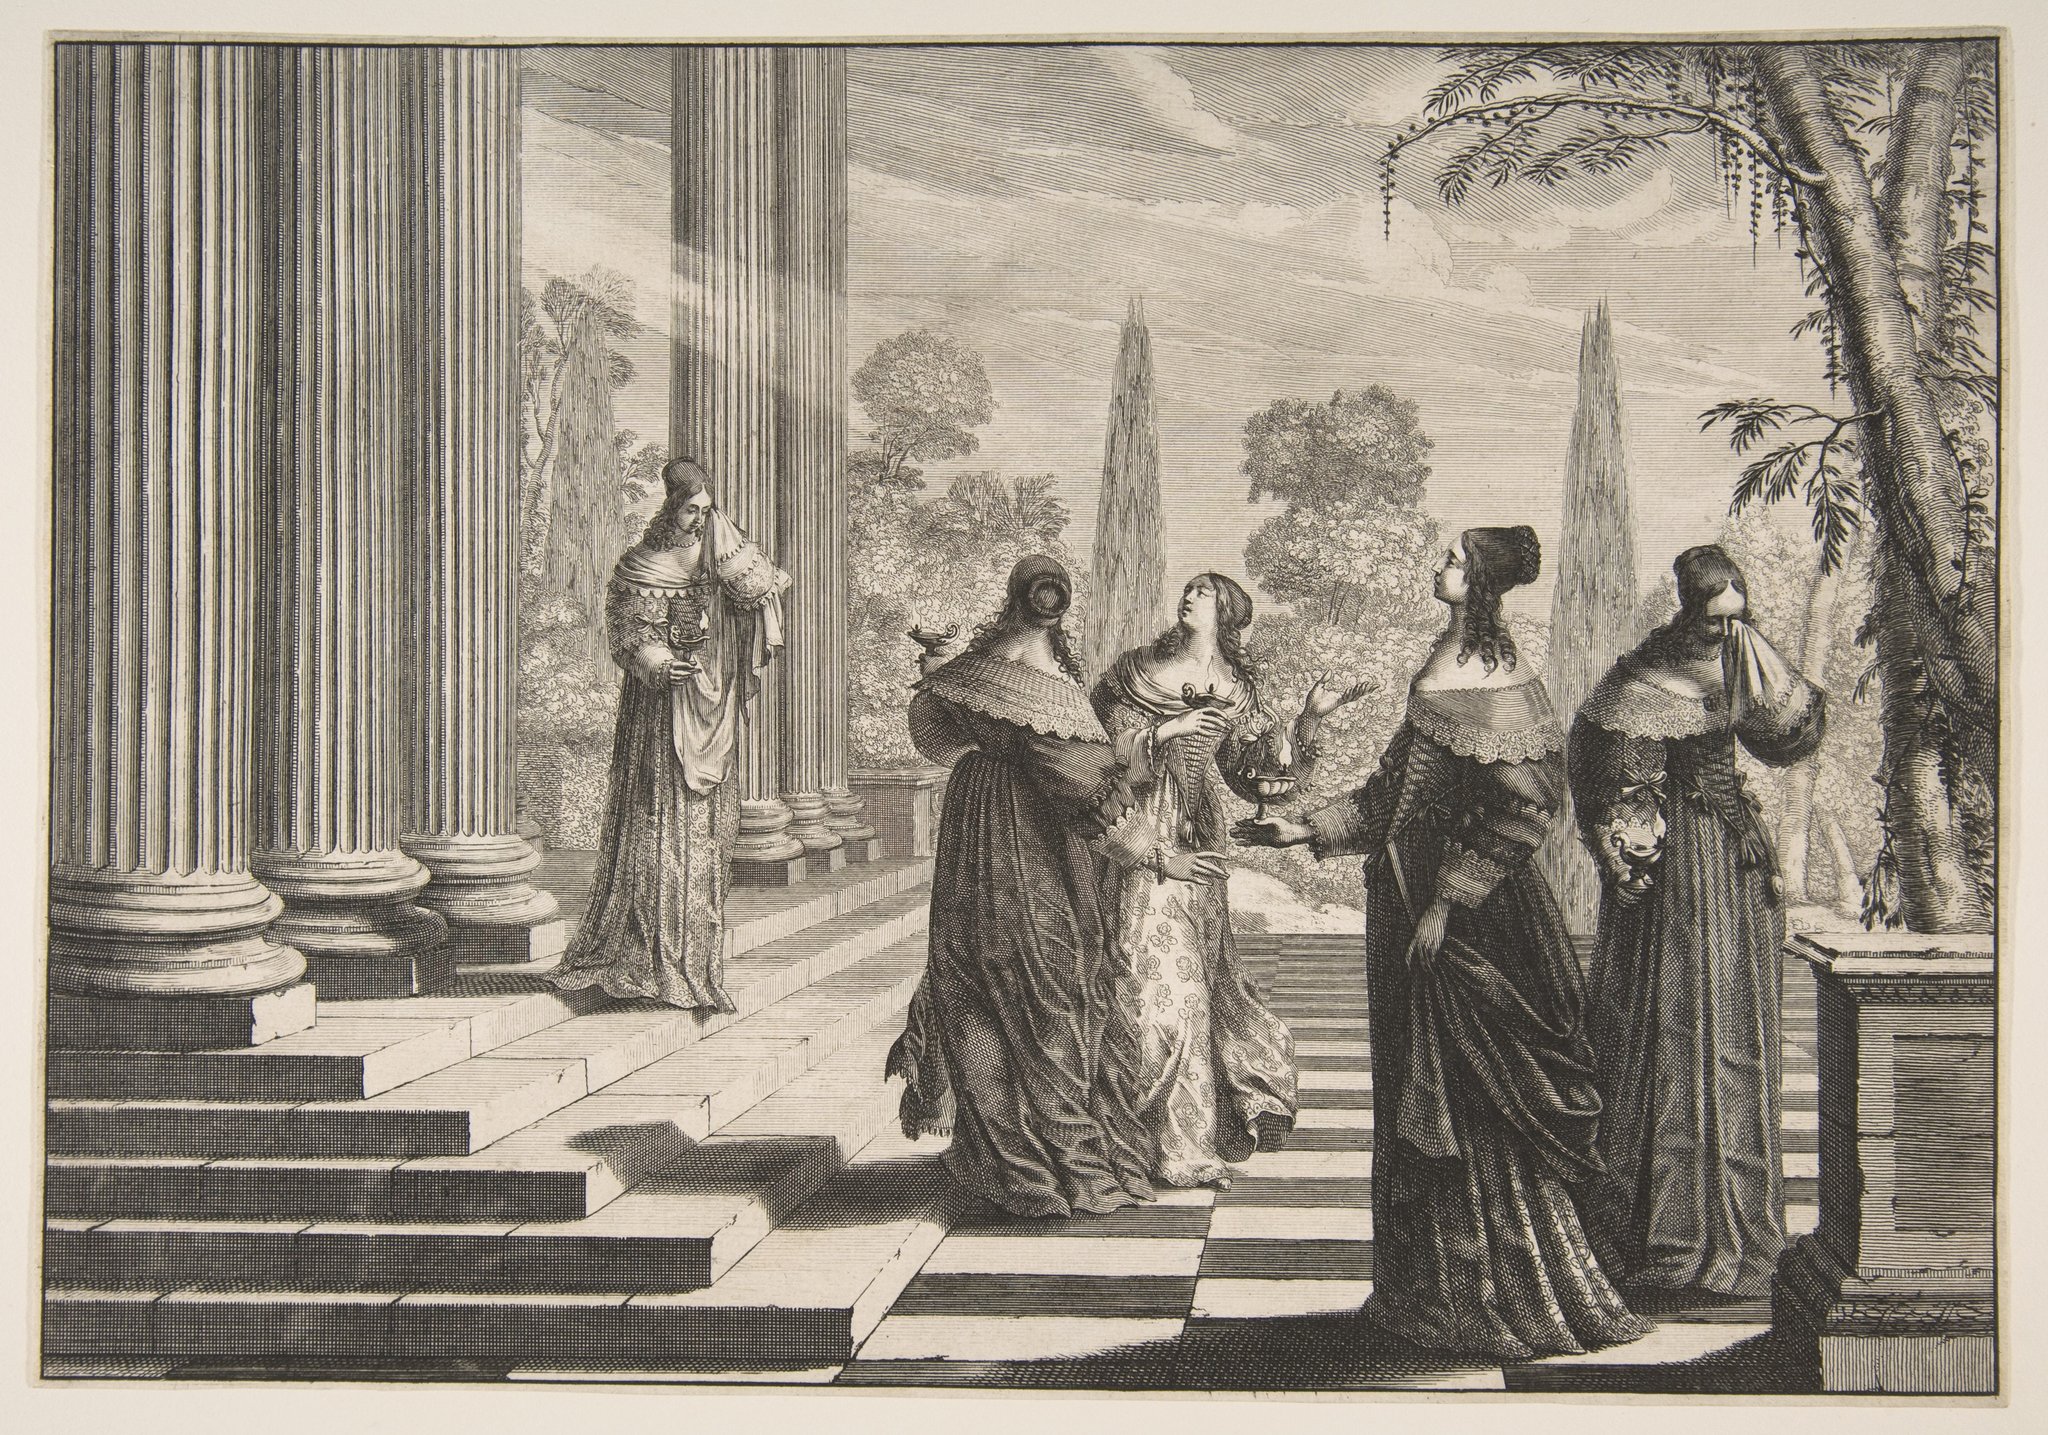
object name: print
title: The Foolish Virgins Rejected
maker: abraham bosse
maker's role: artist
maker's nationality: french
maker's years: 1602-1676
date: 1635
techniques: etching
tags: women